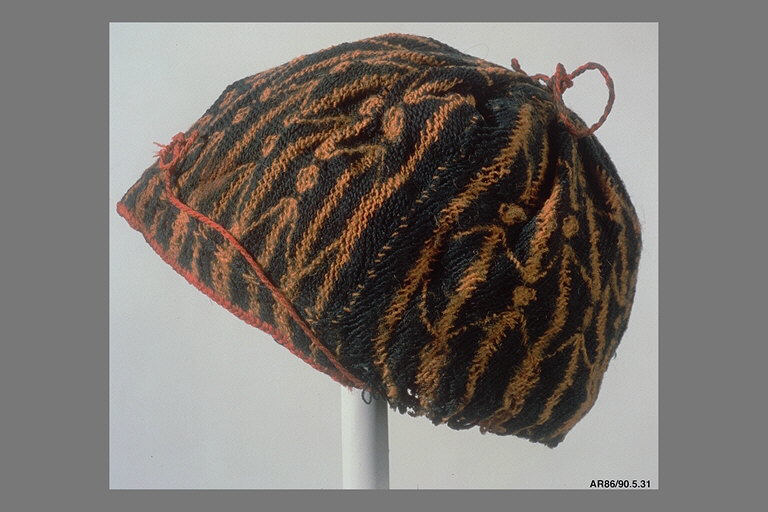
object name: hat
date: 201-500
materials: wool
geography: egypt